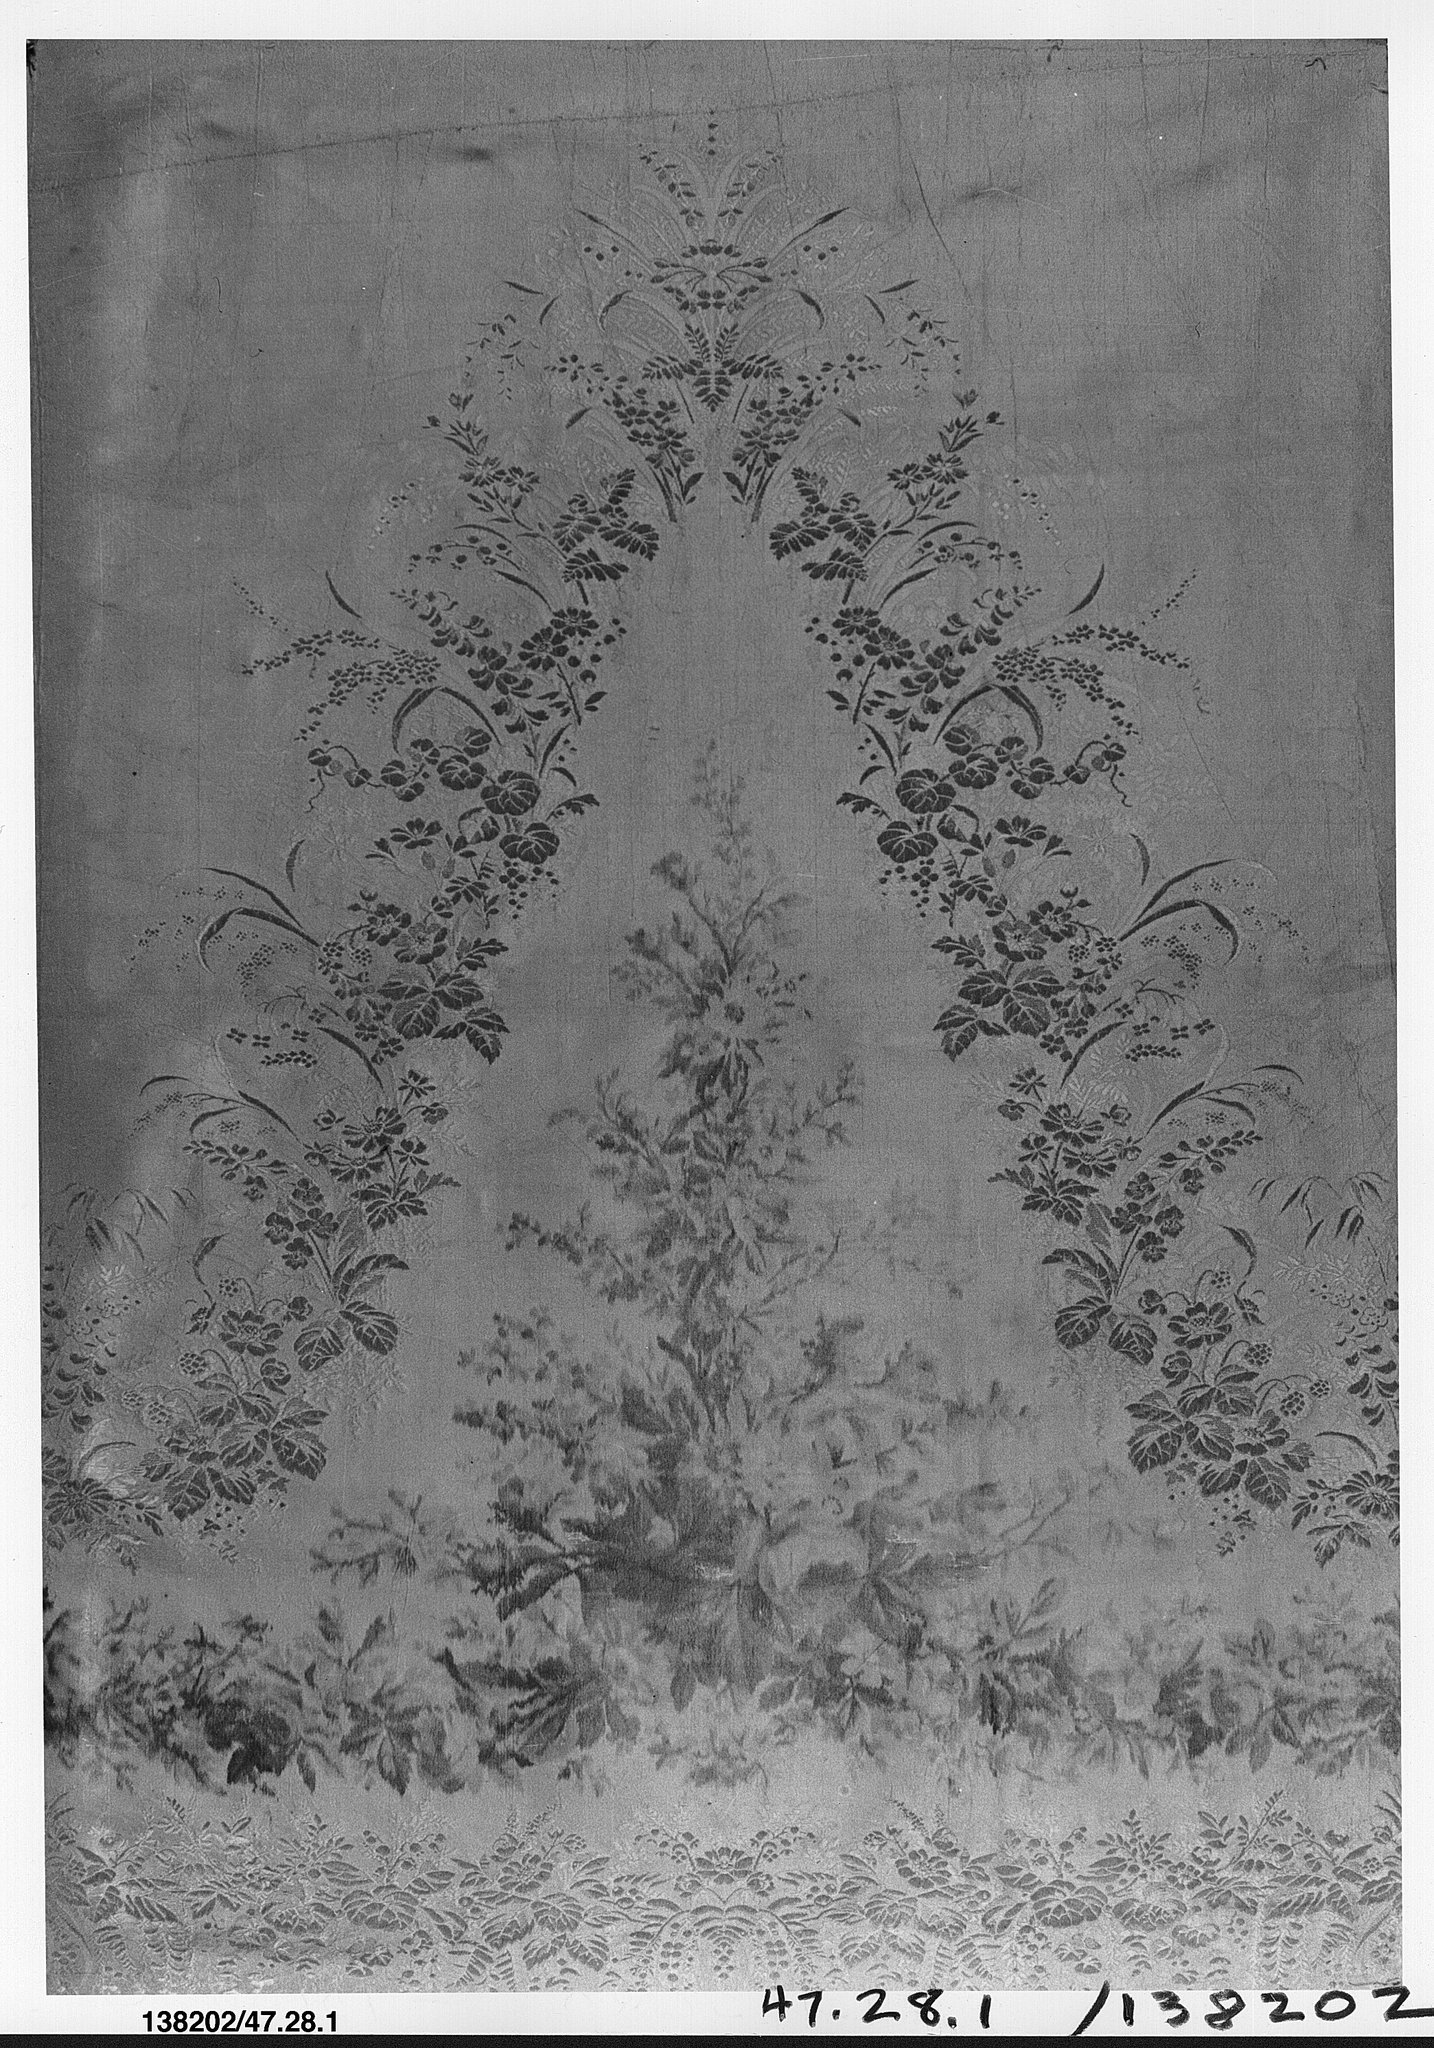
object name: piece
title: Panel for a dress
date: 1850-1860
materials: silk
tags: flowers